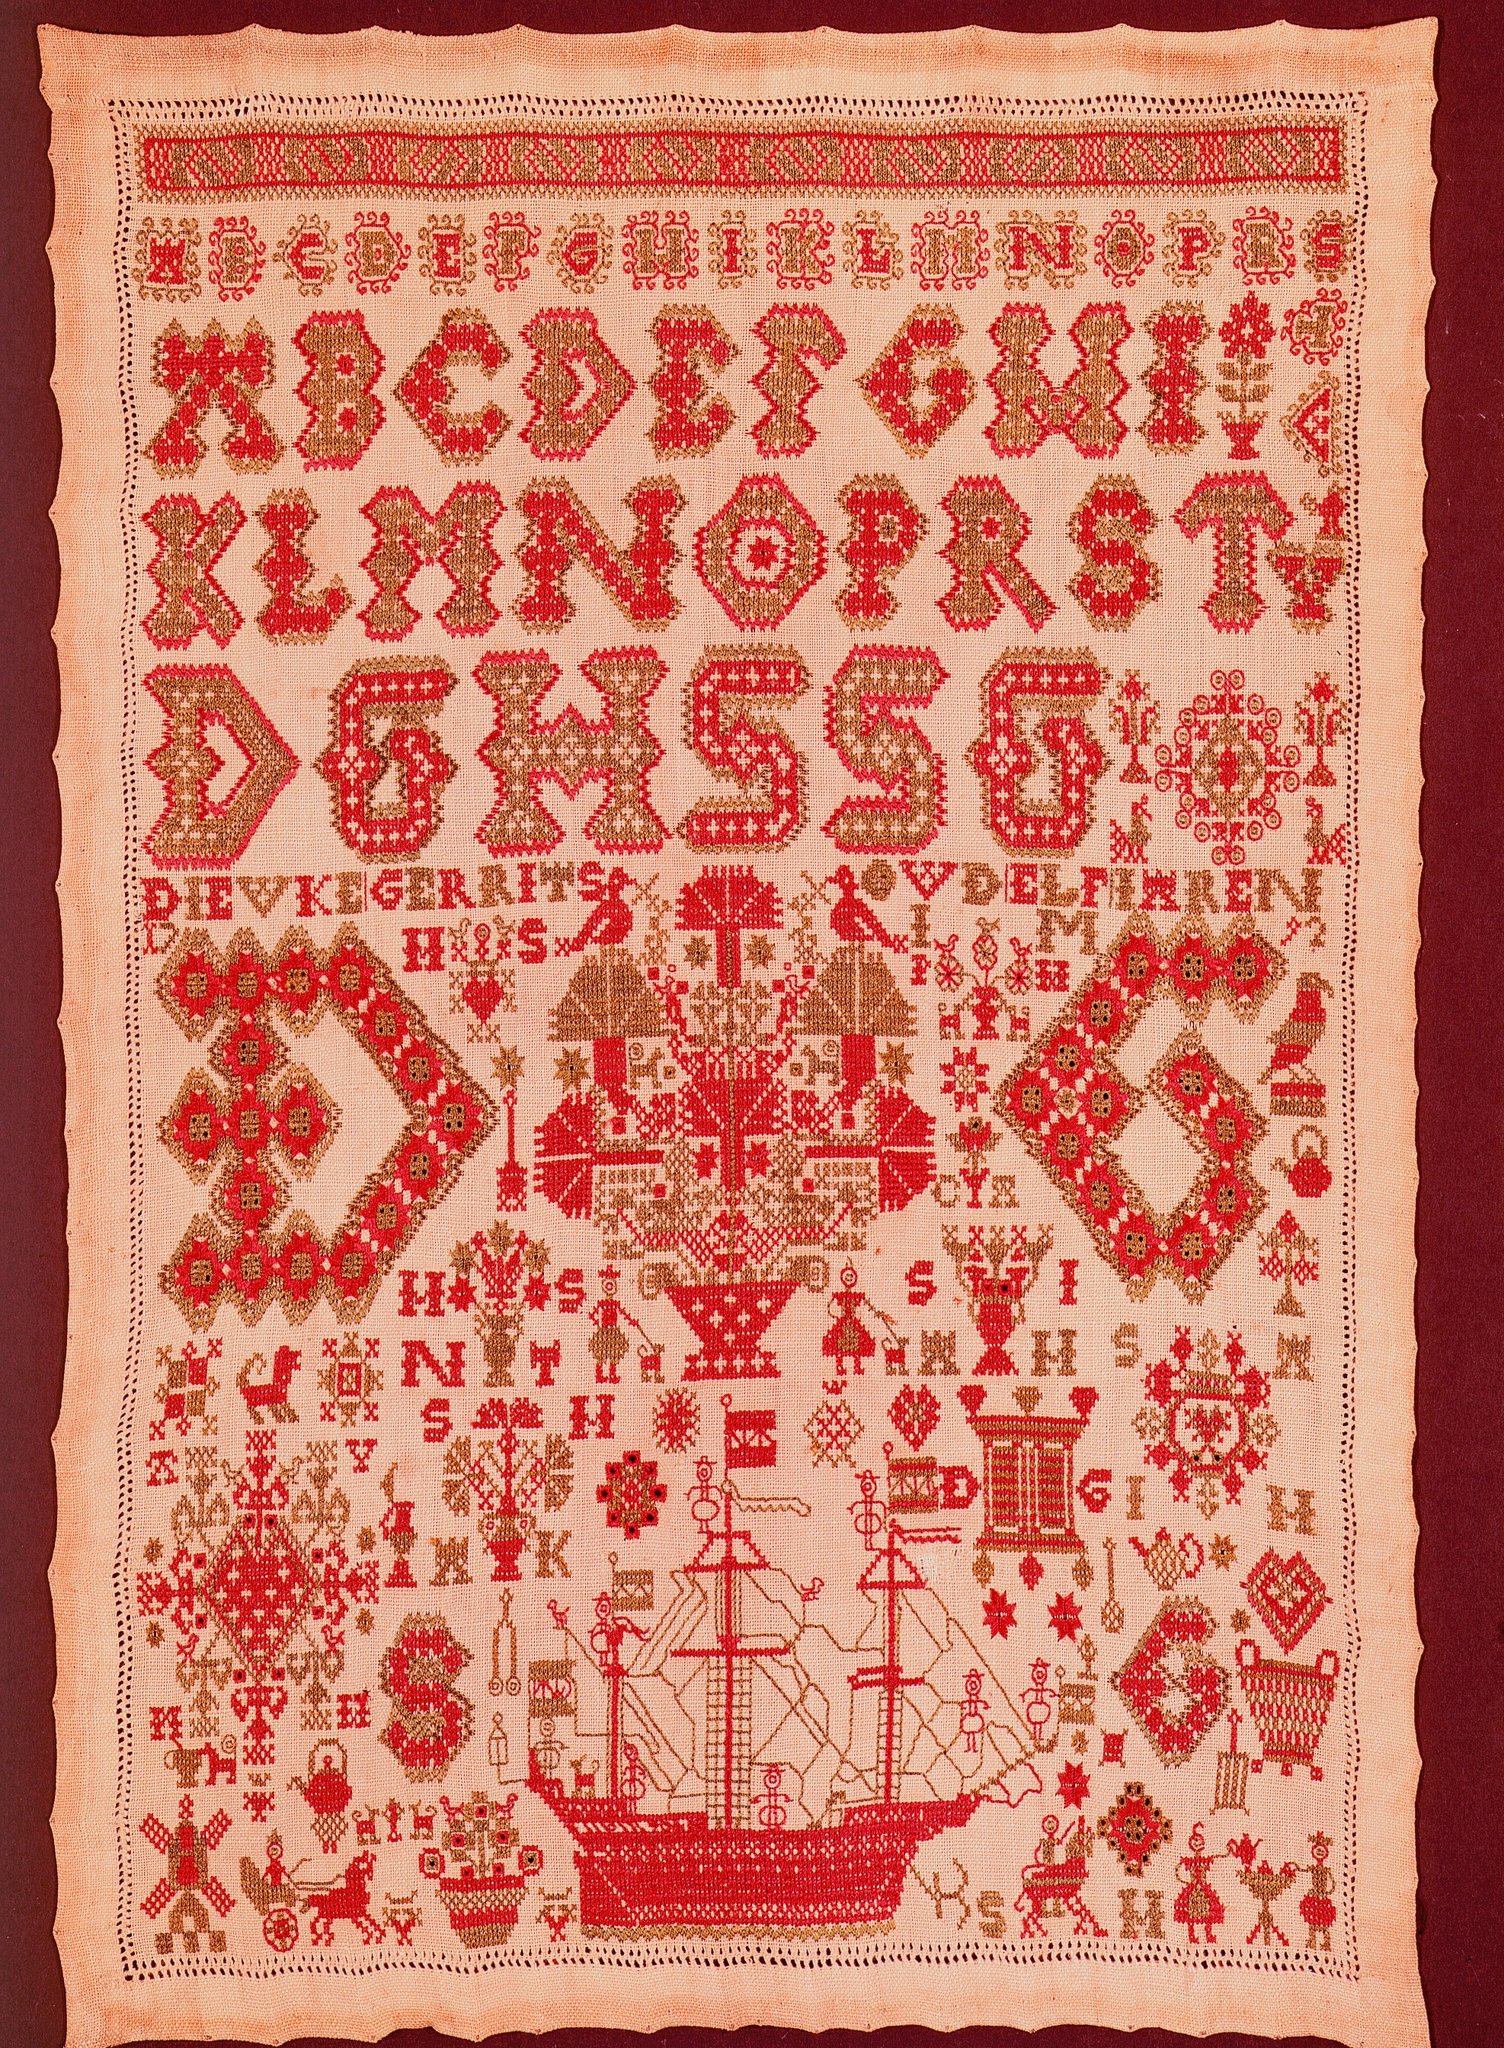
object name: sampler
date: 1792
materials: linen, silk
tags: human figures,horses,ships